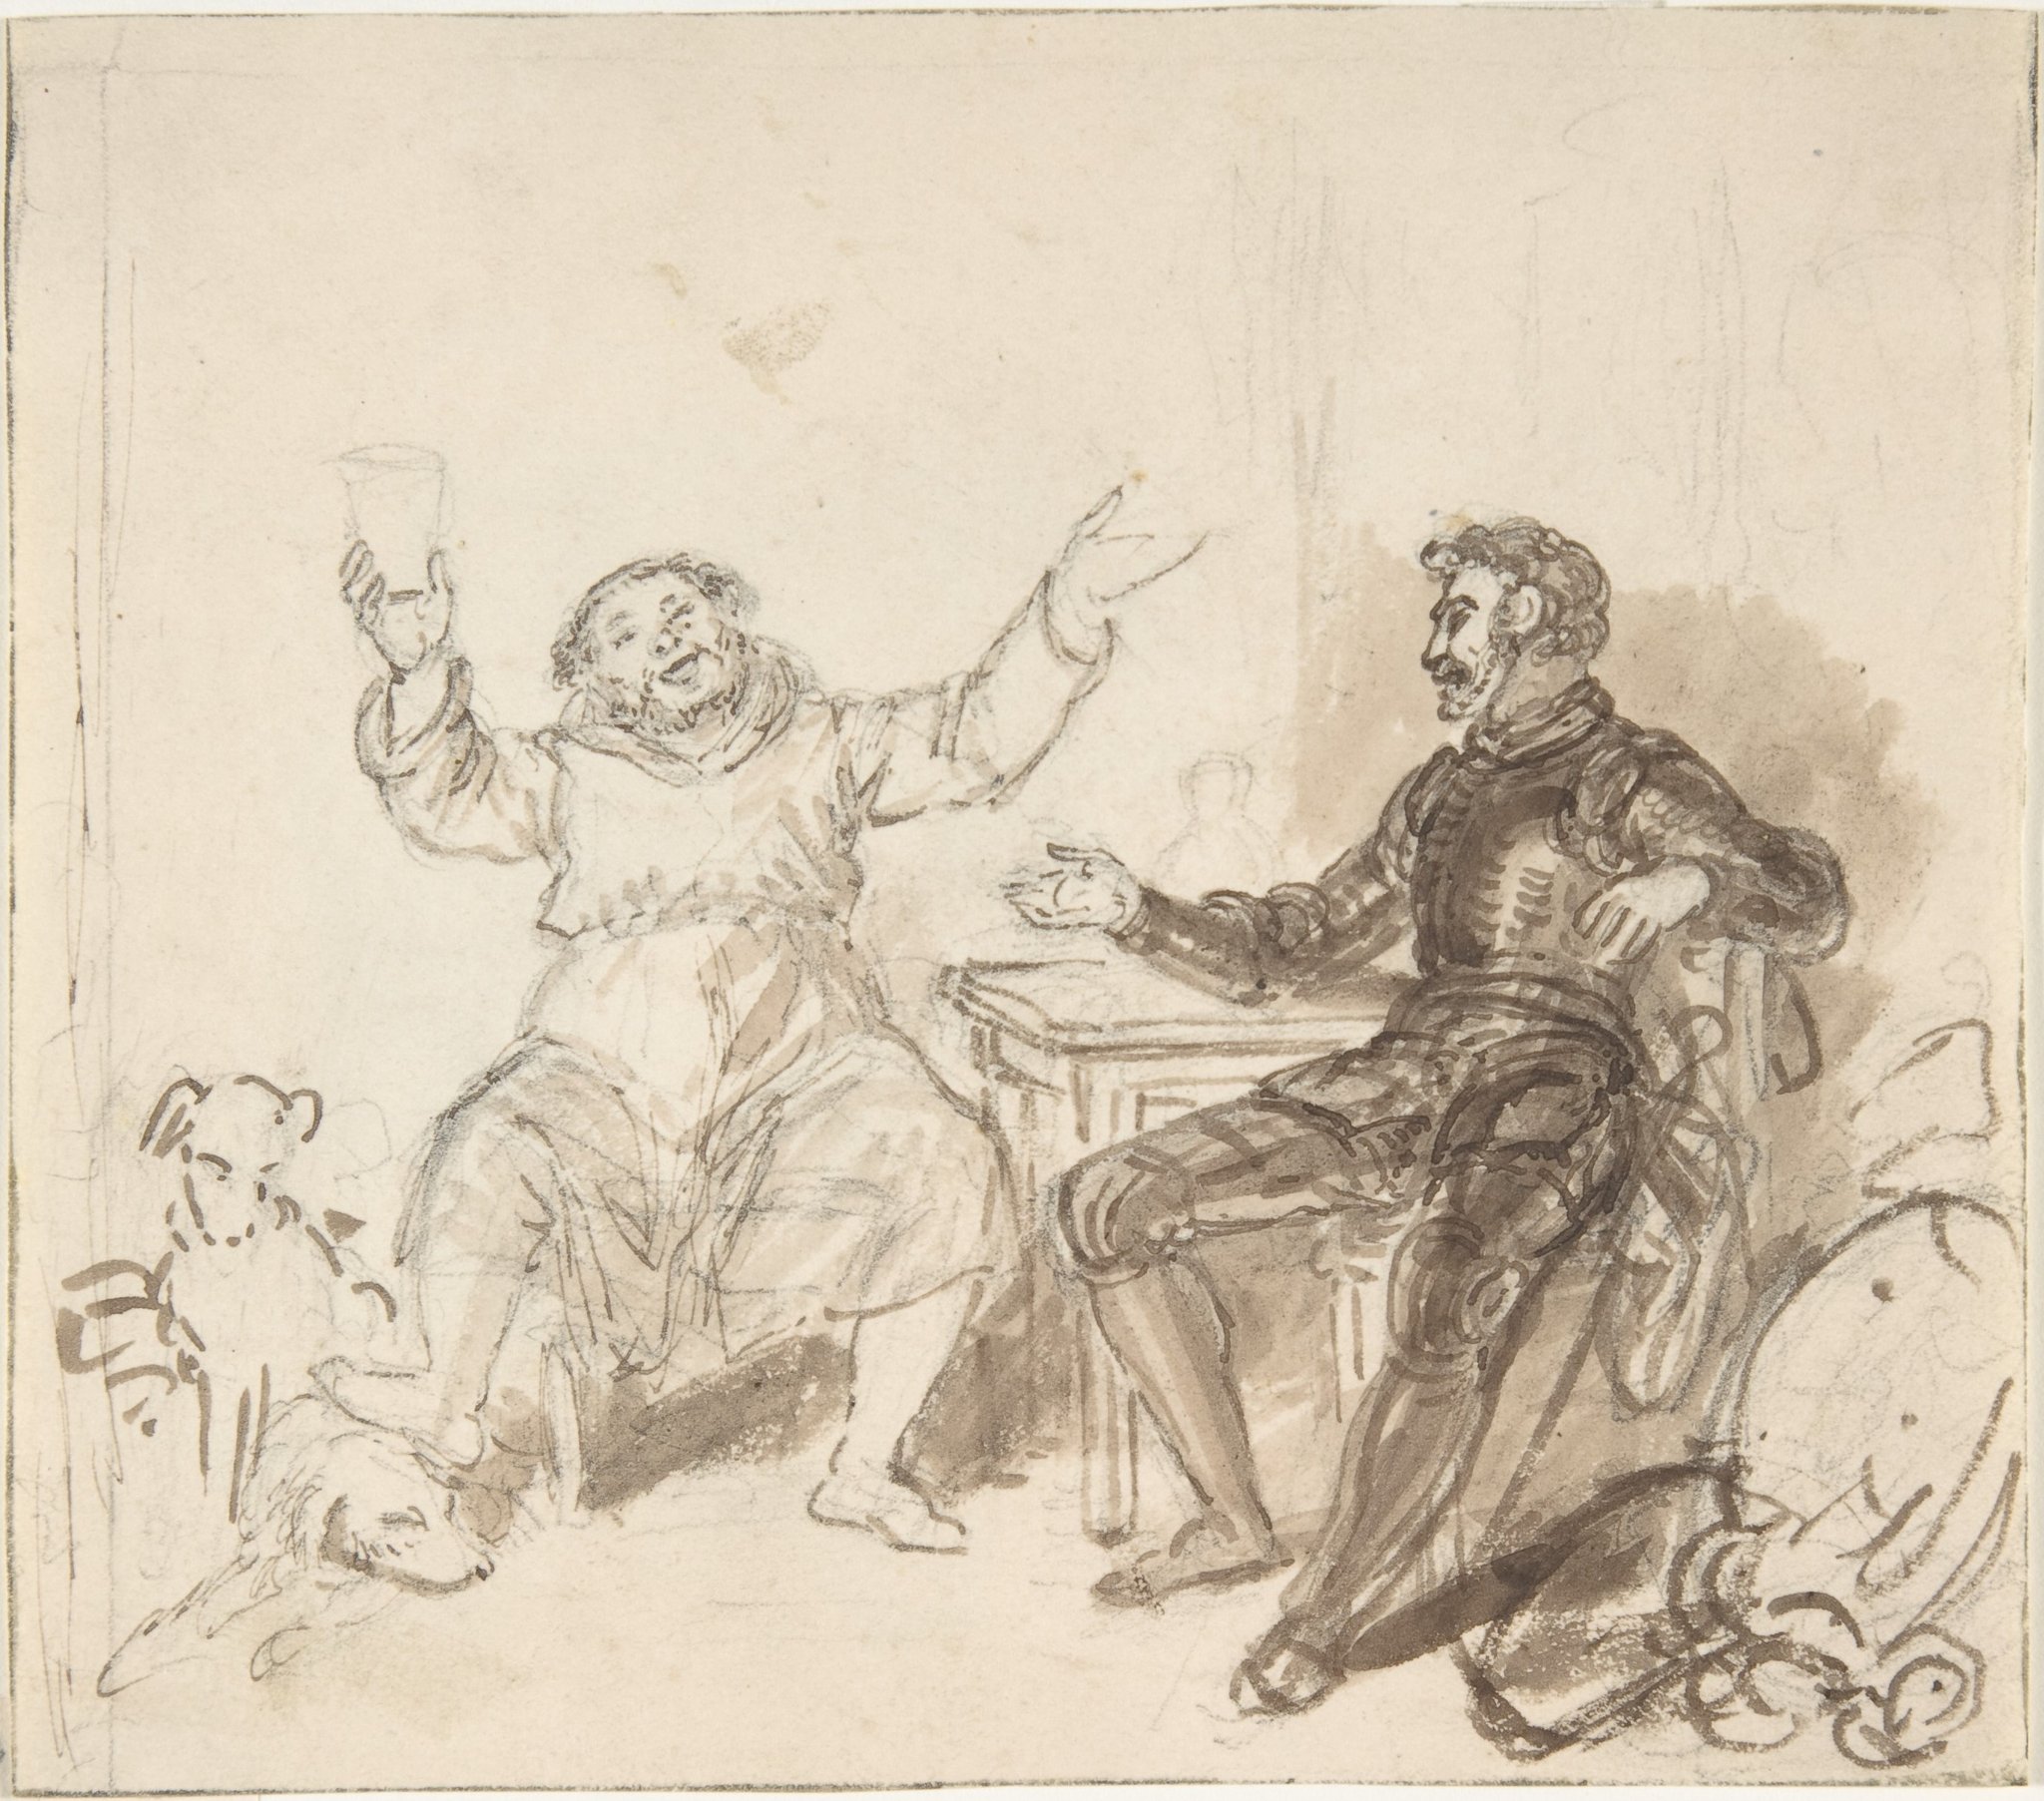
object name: drawing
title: Book illustration: Knight and Monk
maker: john william wright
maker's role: artist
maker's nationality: british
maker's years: 1802-1848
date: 1820-1848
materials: graphite, ink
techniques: brush, pen, wash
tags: dogs,monks,knights